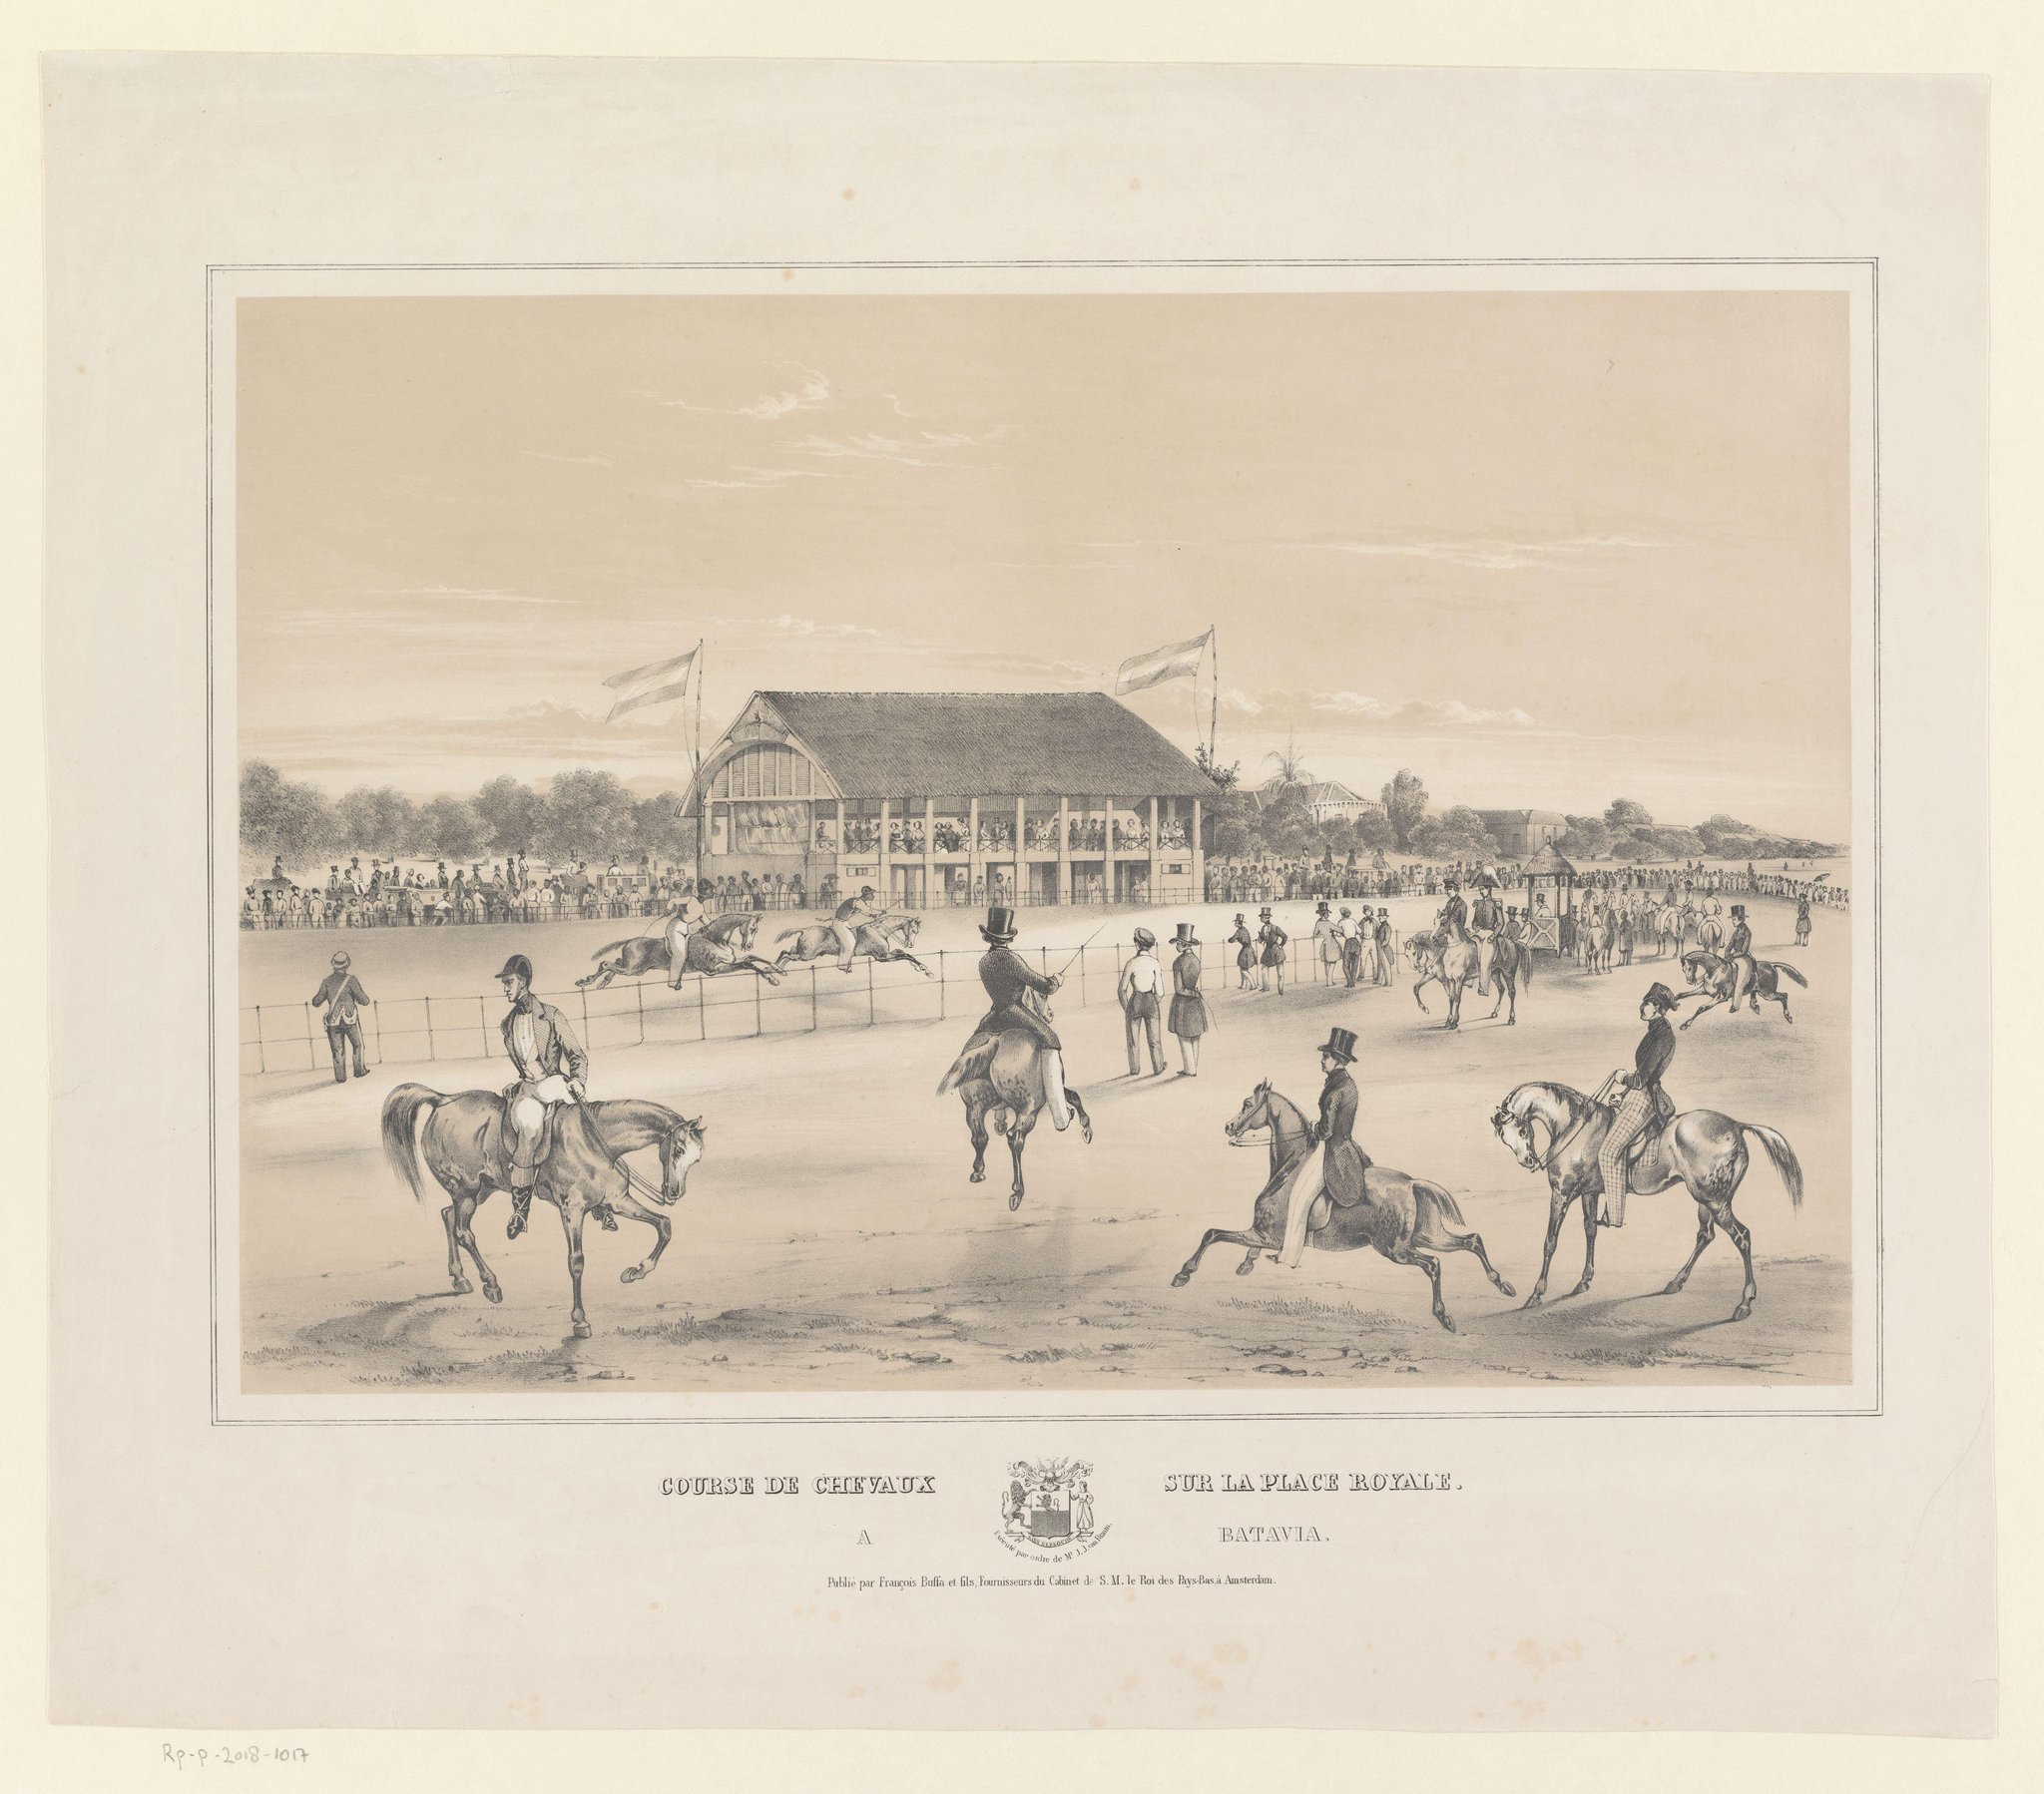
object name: print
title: Course de chevaux sur la Place Royale. A Batavia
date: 1836-1842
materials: paper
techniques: tone lithography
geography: amsterdam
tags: race-track, batavia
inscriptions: collector's mark: Lugt 2228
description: Toeschouwers kijken naar paardenrennen op de renbaan op het Koningsplein te Batavia. Op de voorgrond ruiters te paard.